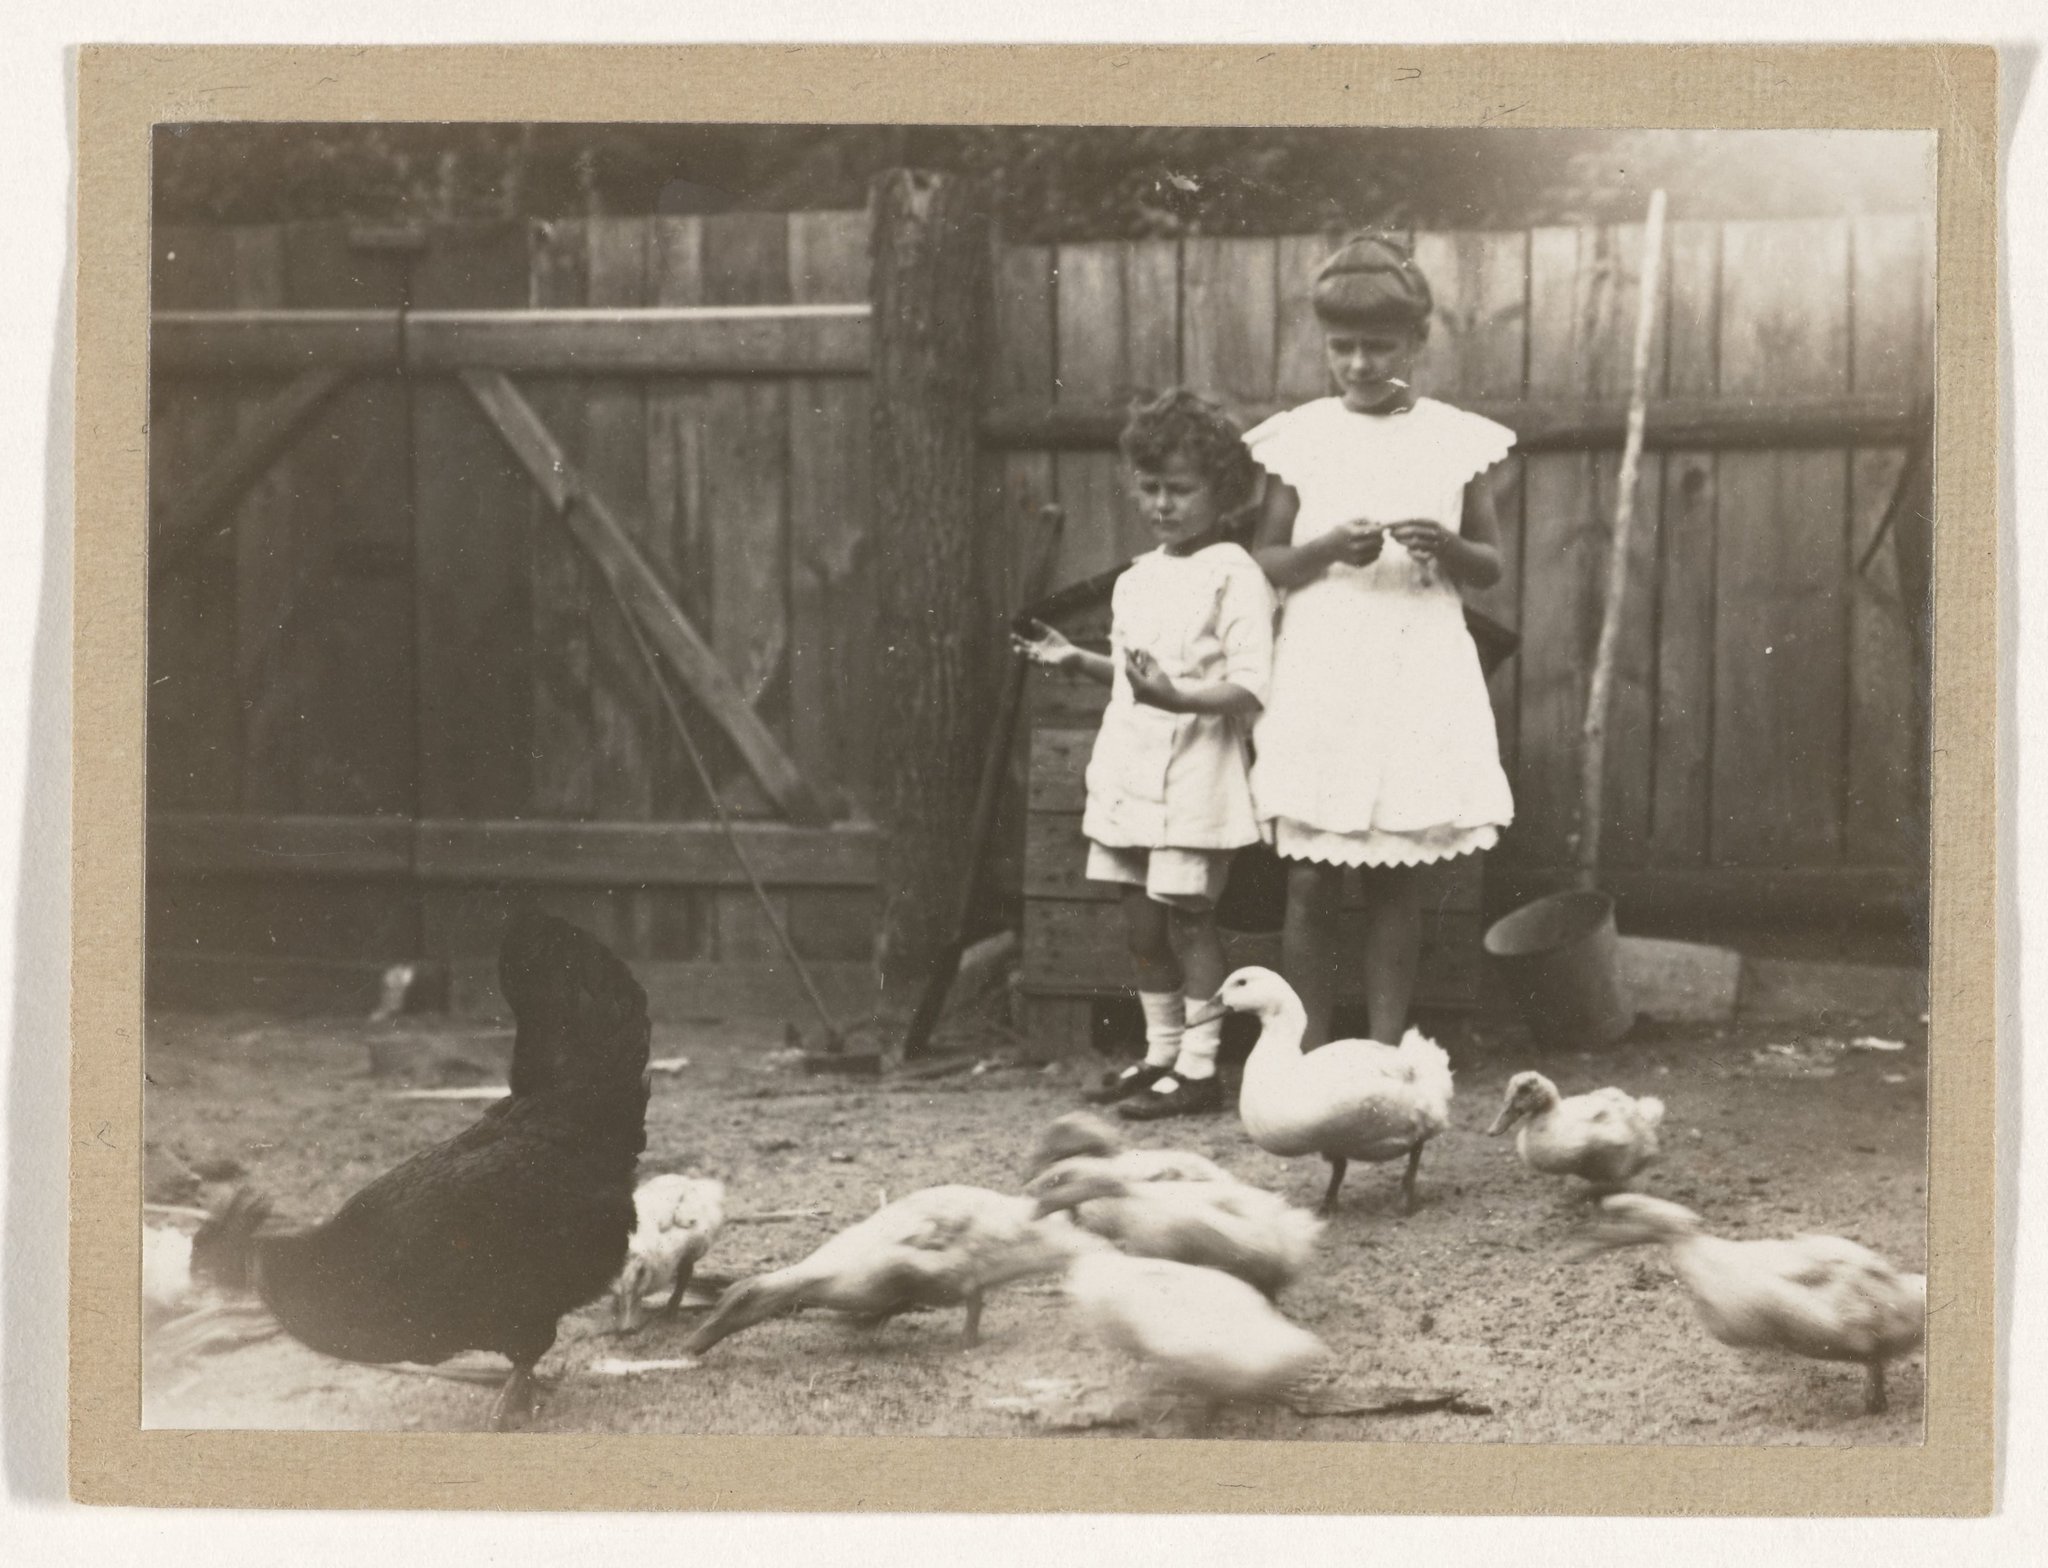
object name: photograph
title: Marba en Eckart Titzenthaler, kinderen van de fotograaf, op een erf met kippen en eenden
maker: waldemar titzenthaler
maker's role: fotograaf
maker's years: 1869-1937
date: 1918-1919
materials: paper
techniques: gelatin silver print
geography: germany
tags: boy (child between toddler and youth), girl (child between toddler and youth), fowl (cock, hen, chicken, etc.), germany